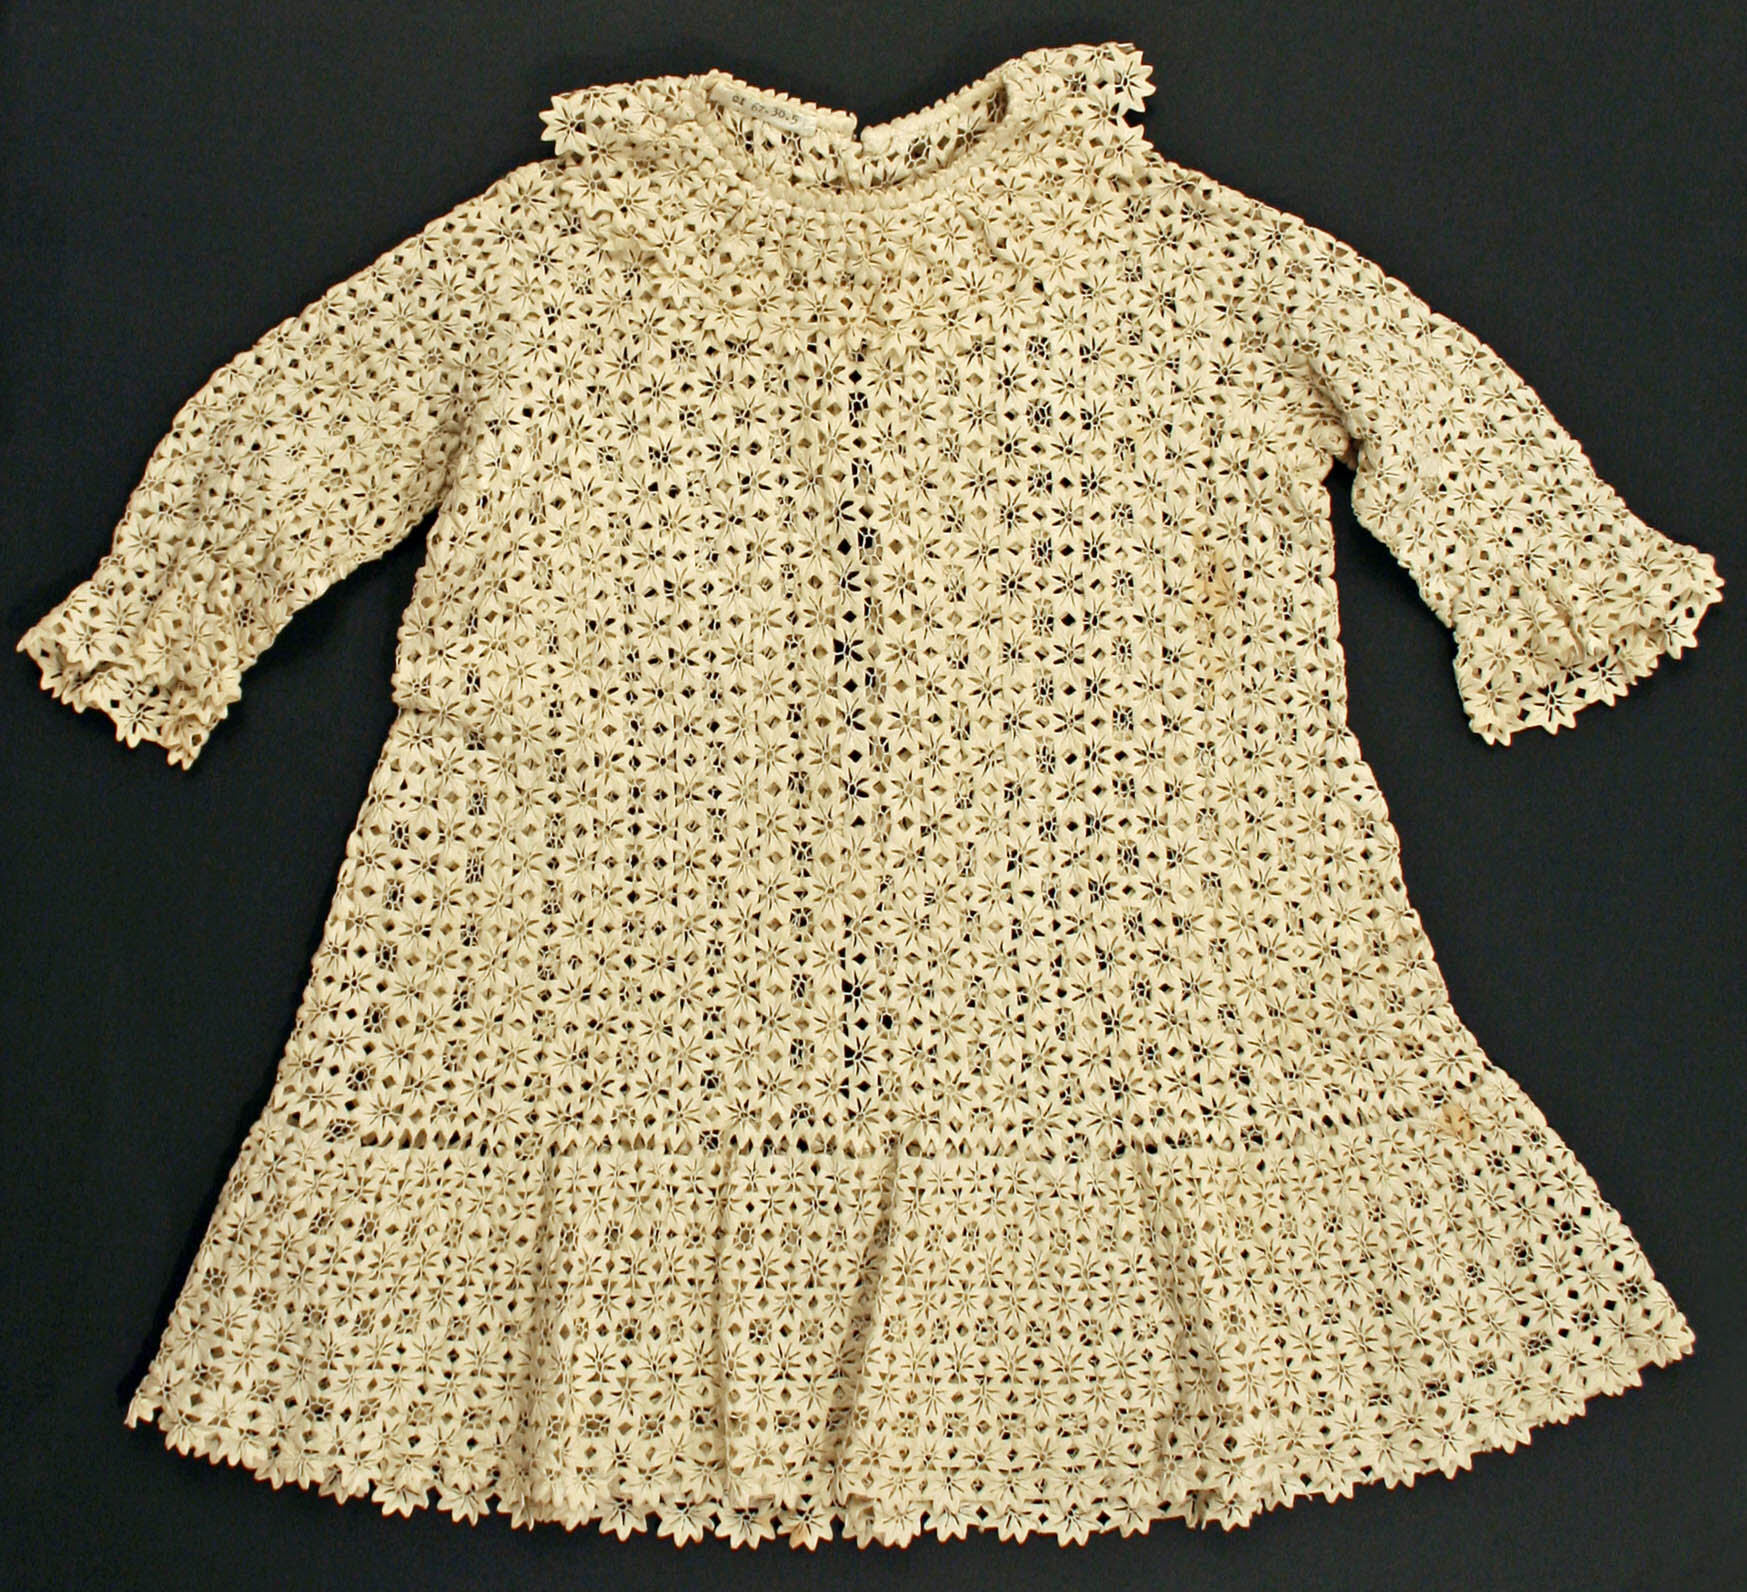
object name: dress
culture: american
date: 1882